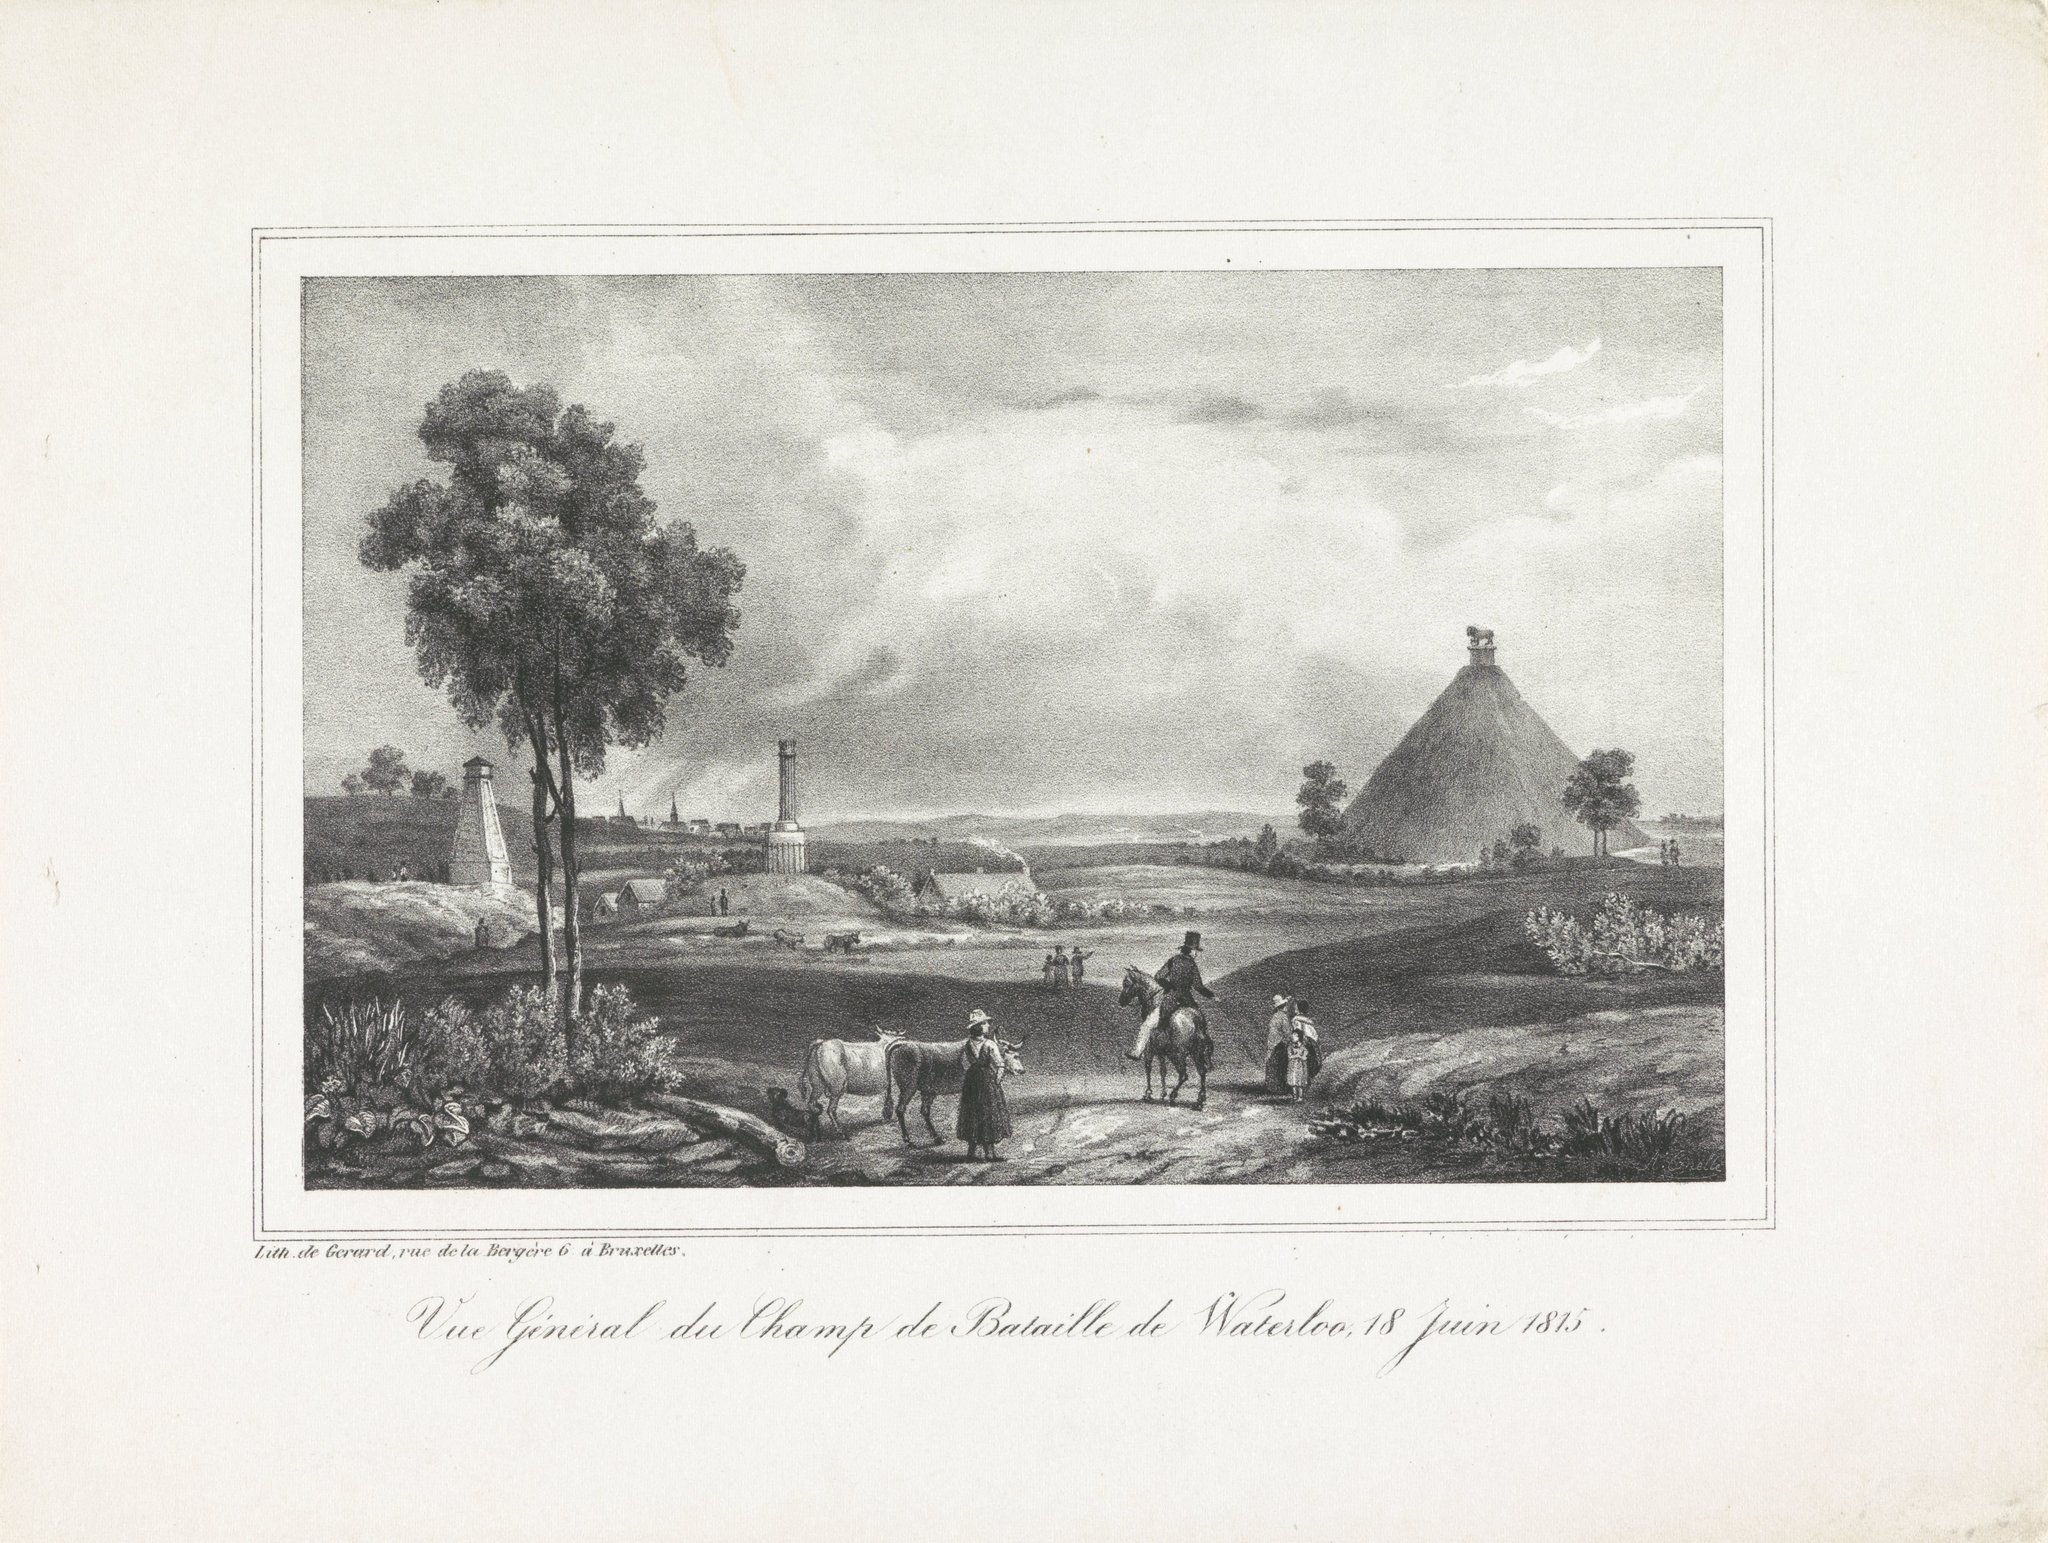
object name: print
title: Slagveld van Waterloo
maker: h. gérard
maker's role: printer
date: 1842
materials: paper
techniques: lithograph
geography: brussels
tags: landscape with monument, waterloo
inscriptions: collector's mark: Lugt 2228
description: Gezicht over het slagveld van Waterloo. Rechts het monument. Onderdeel van een serie van twaalf platen (aangevuld tot veertien) met gezichten uit ca. 1840 van de omgeving waar de slag bij Waterloo plaatsvond op 18 juni 1815.